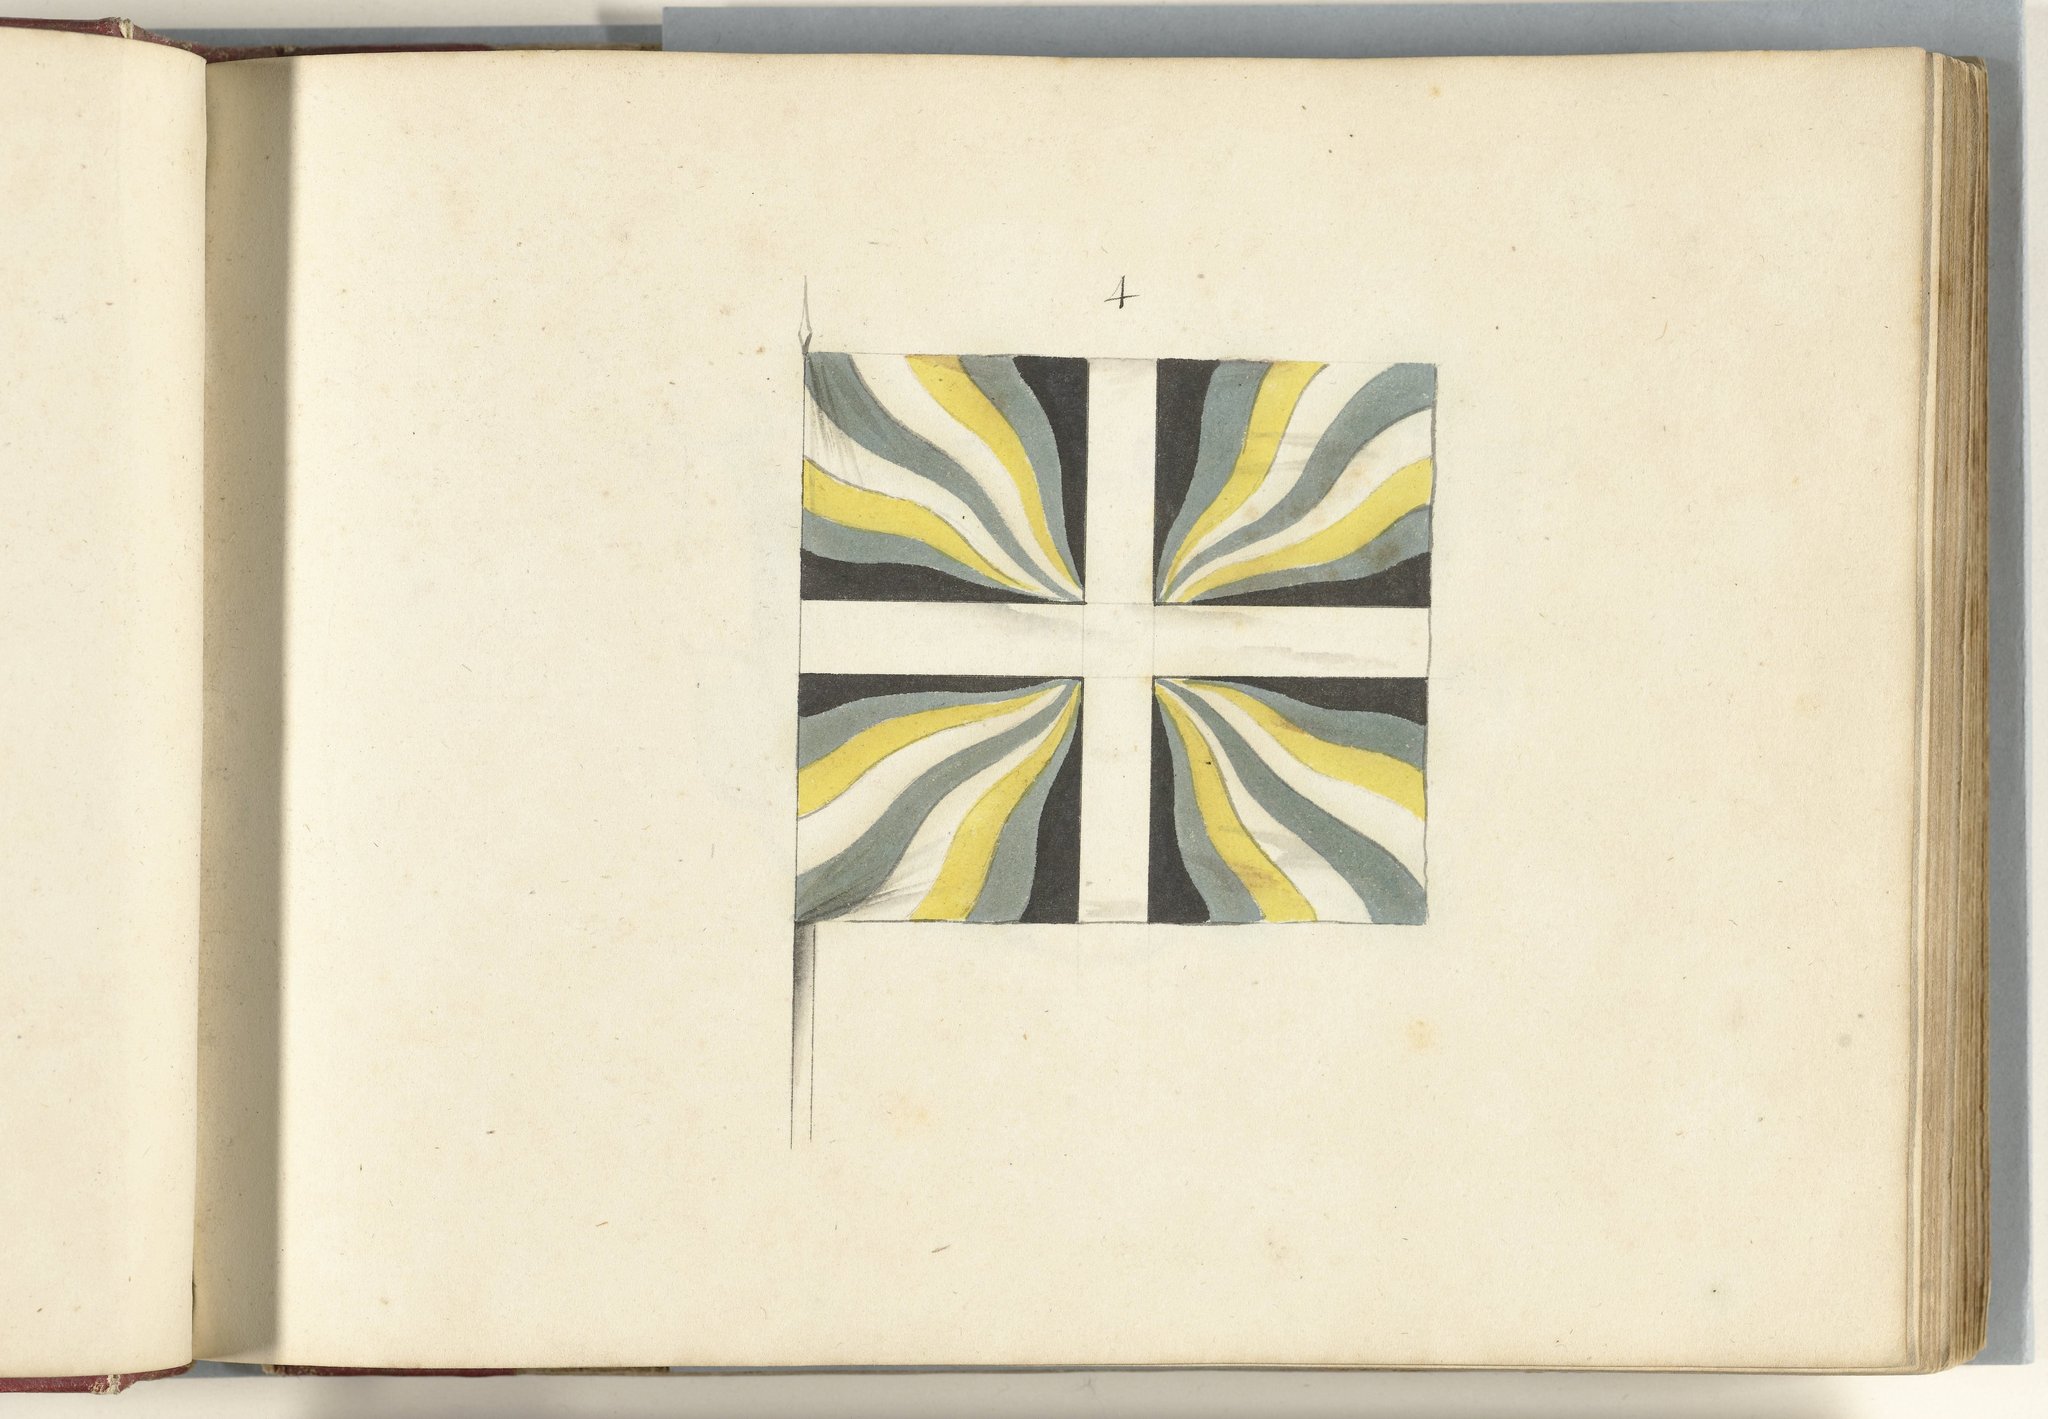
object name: drawing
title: Frans vaandel veroverd bij Huy, 1703-1705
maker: Anonymous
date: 1713-1720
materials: paper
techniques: drawing, writing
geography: northern netherlands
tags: (military) flags and standards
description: Frans vaandel veroverd bij Huy, in 1703 of in 1705. In het boek met tekeningen van Franse vaandels, standaarden en pauken, veroverd tijdens de Spaanse Successieoorlog (1701-1713).